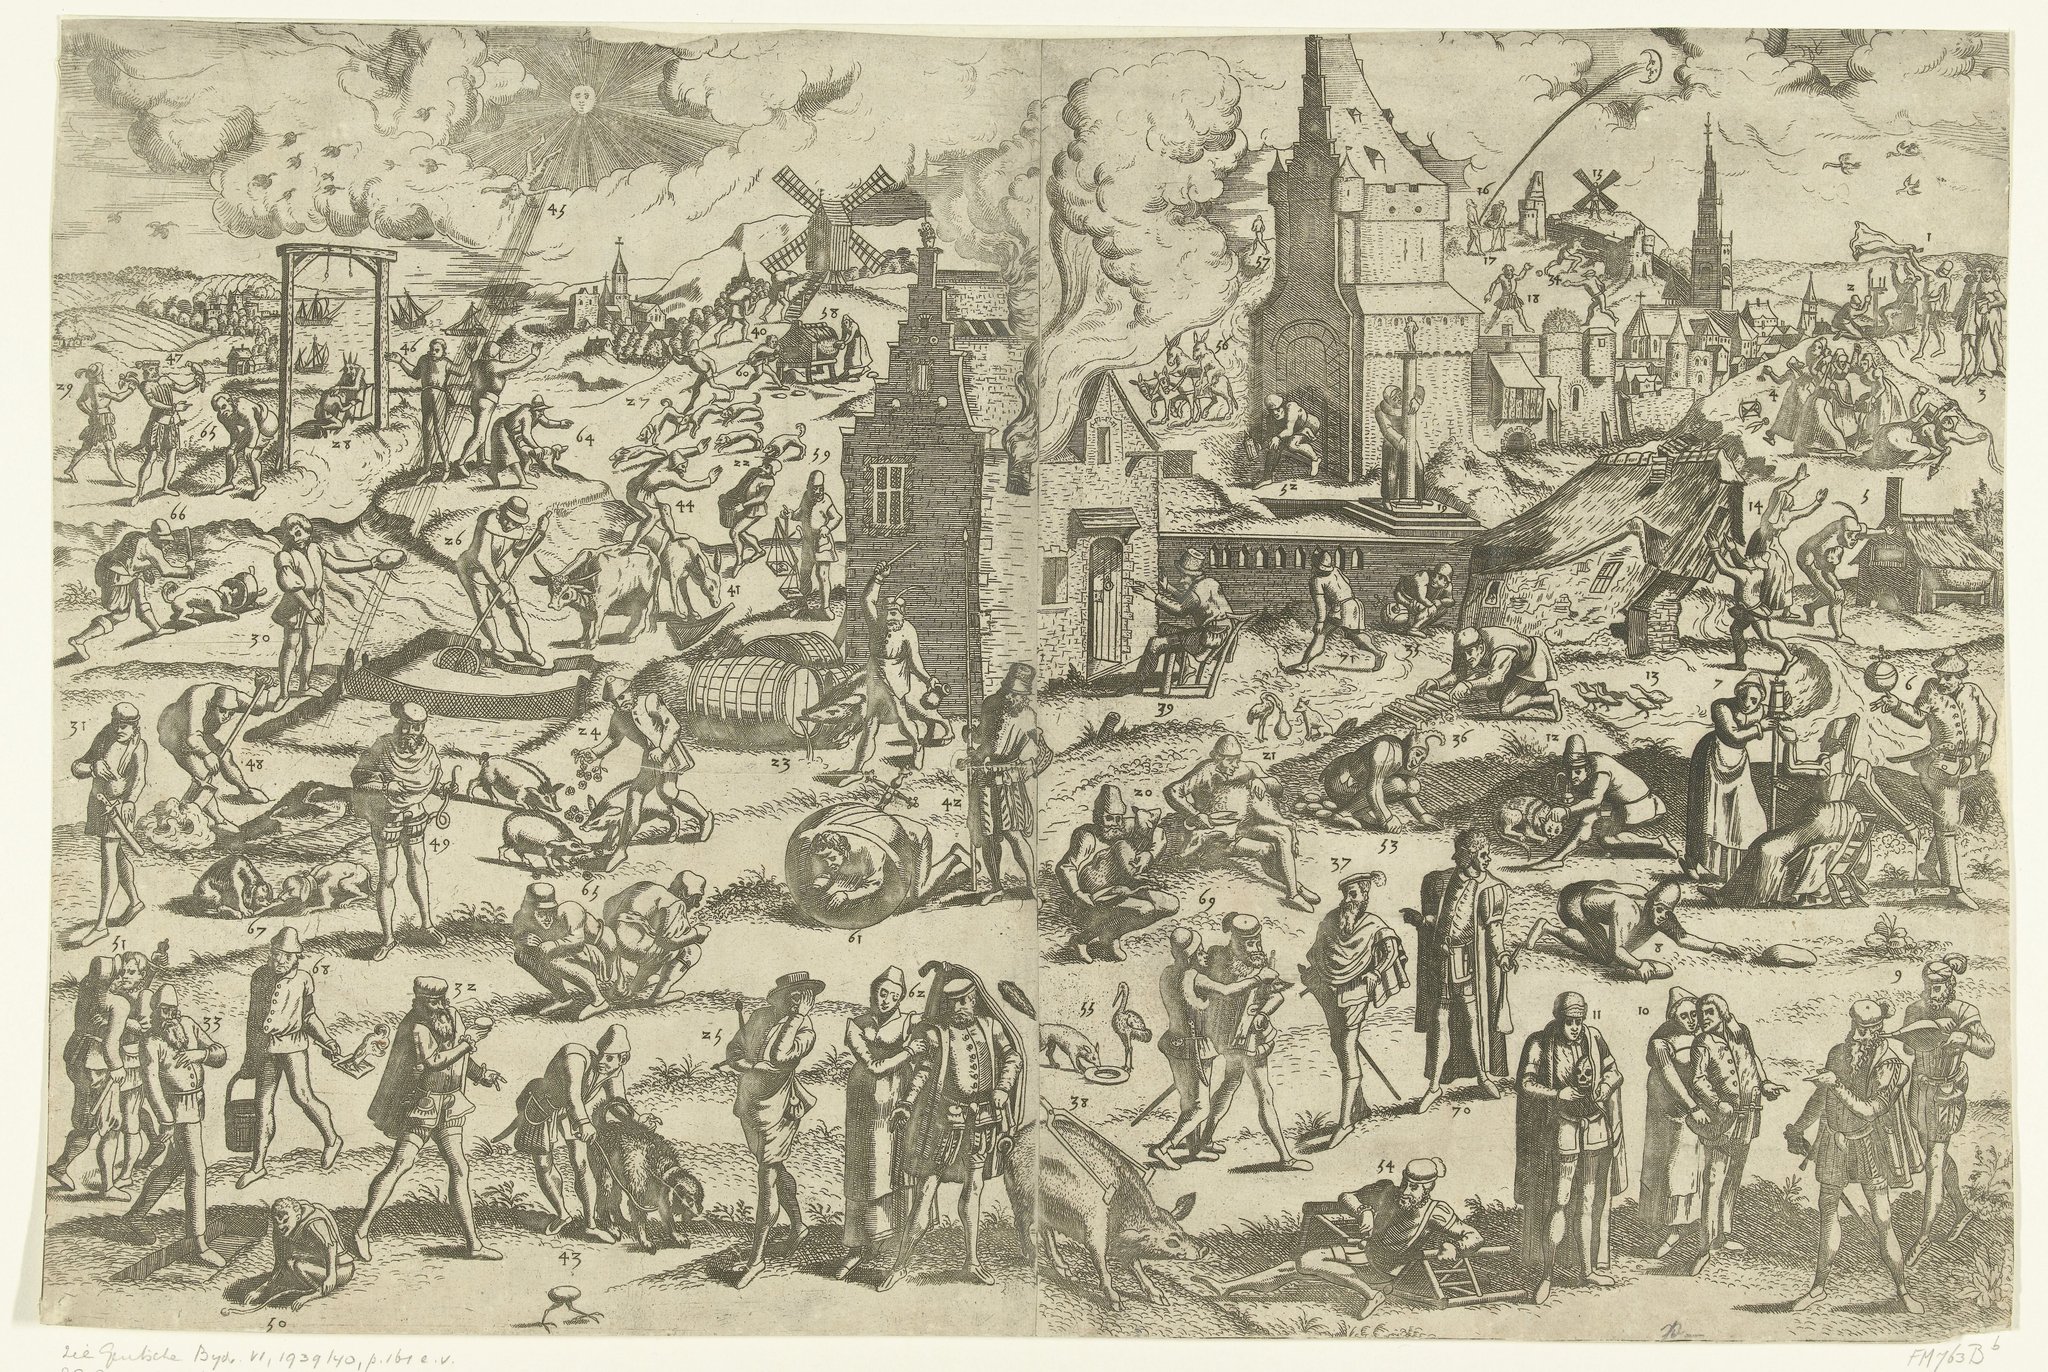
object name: print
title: De Blauwe Huyck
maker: Anonymous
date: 1577-1599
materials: paper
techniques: etching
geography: low countries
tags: proverbs, sayings, etc.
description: De Blauwe Huyck, 71 genummerde spreekwoorden verbeeld in een fantasielandschap.